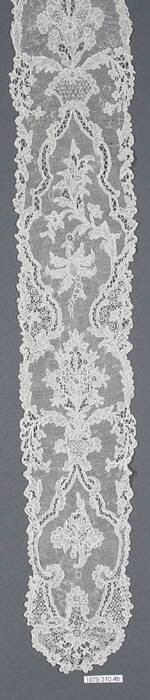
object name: lappet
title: Lappet (one of a pair)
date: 1734-1766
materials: linen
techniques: lace